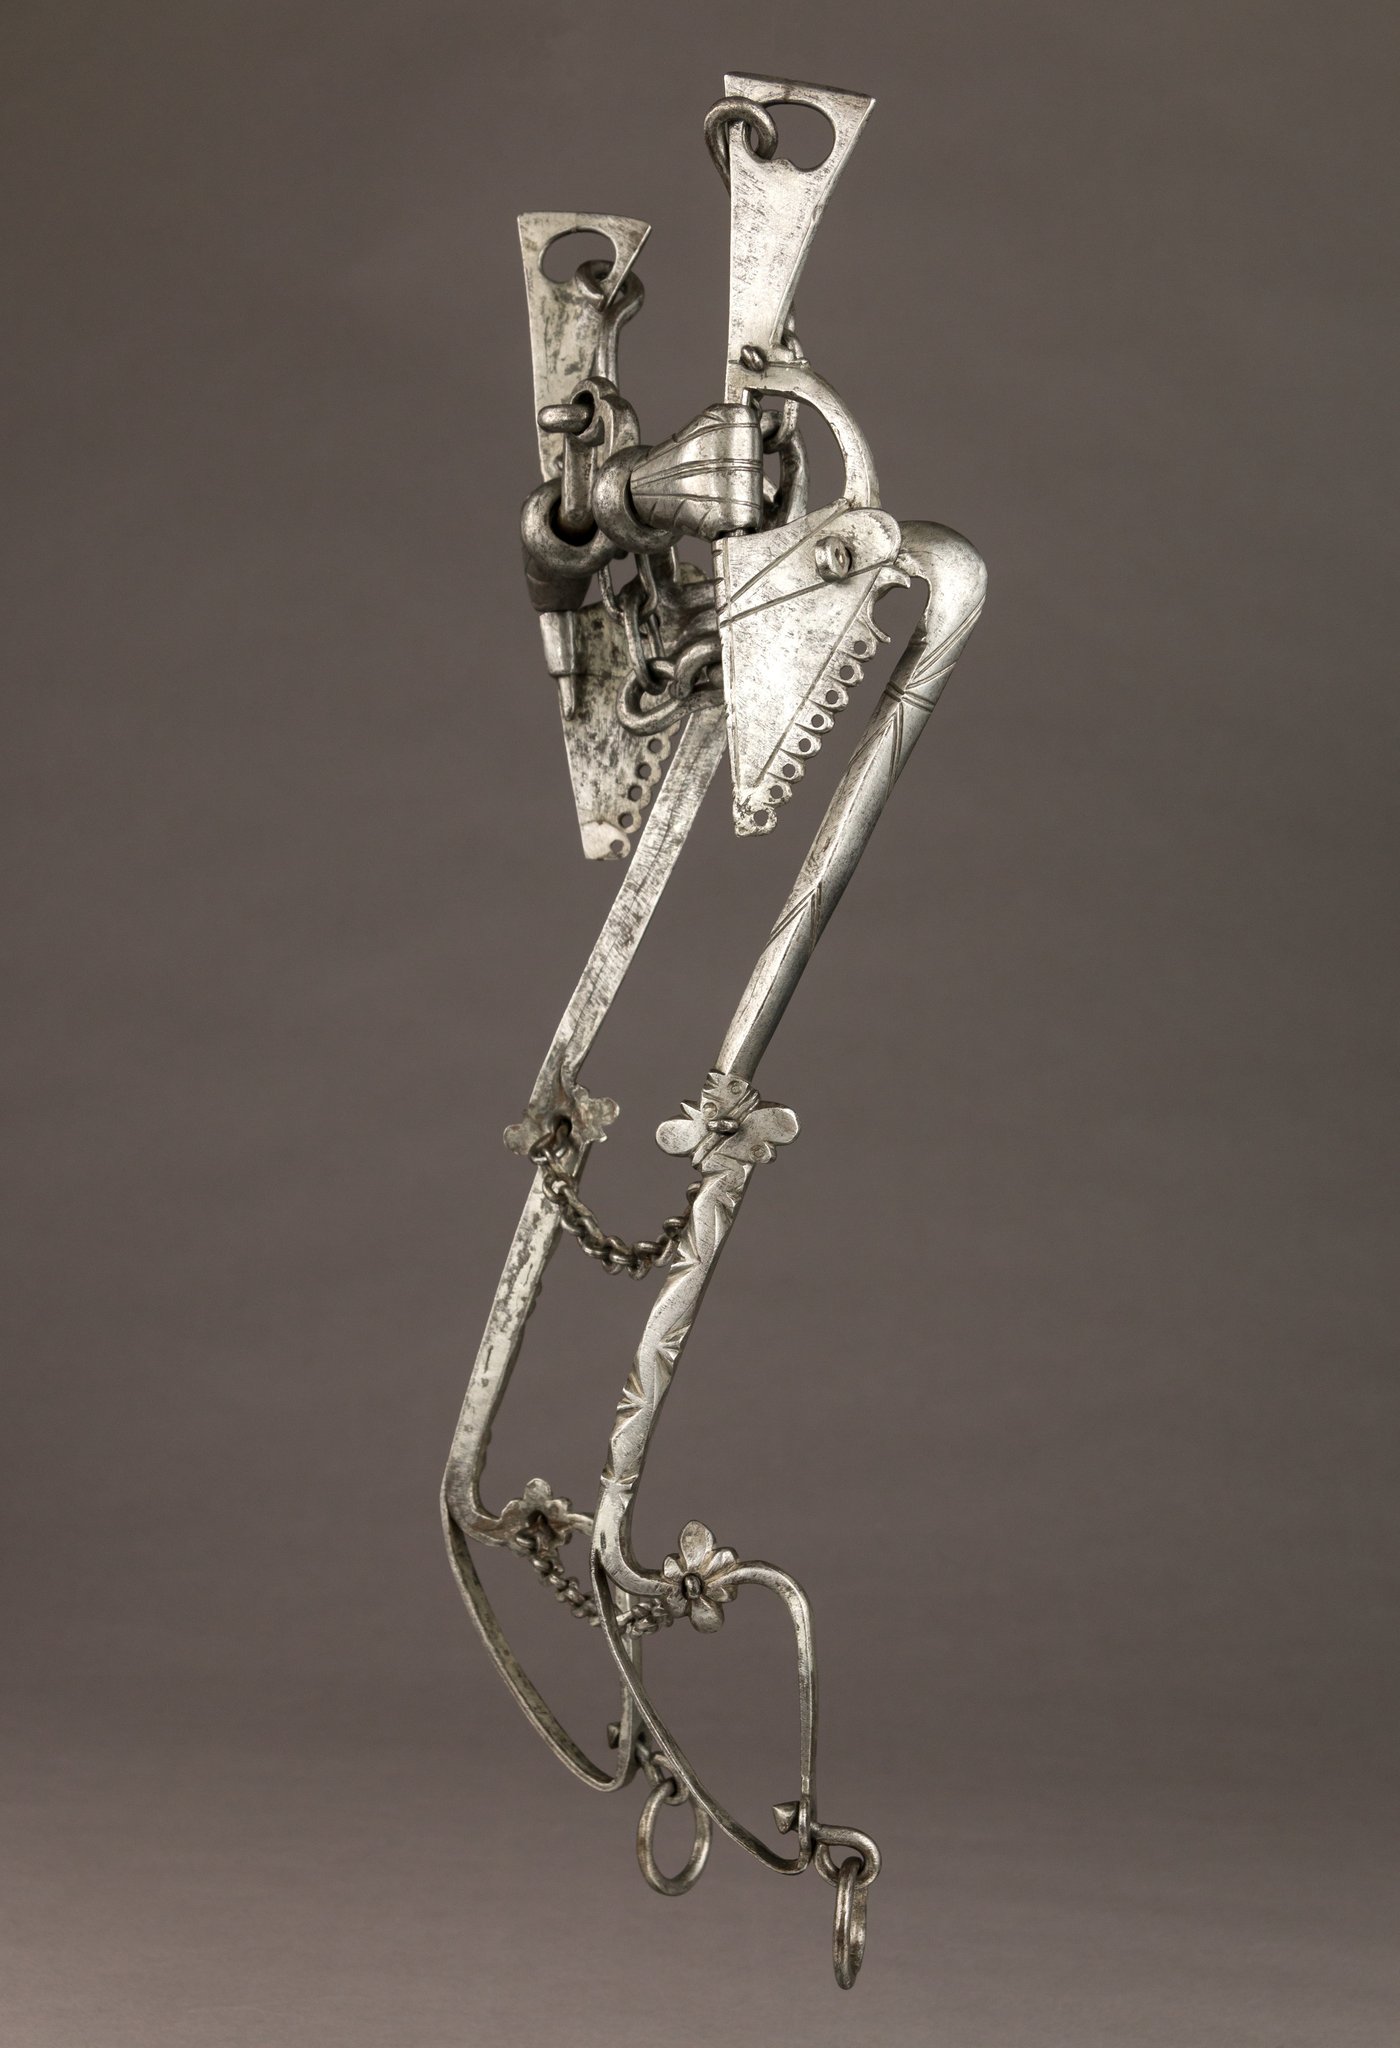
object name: bit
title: Curb Bit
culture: german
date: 1601-1700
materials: metal alloy, tin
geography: germany